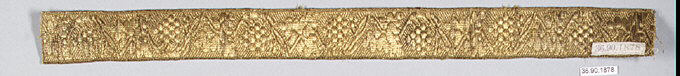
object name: galloon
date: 1767-1833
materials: metal thread, silk